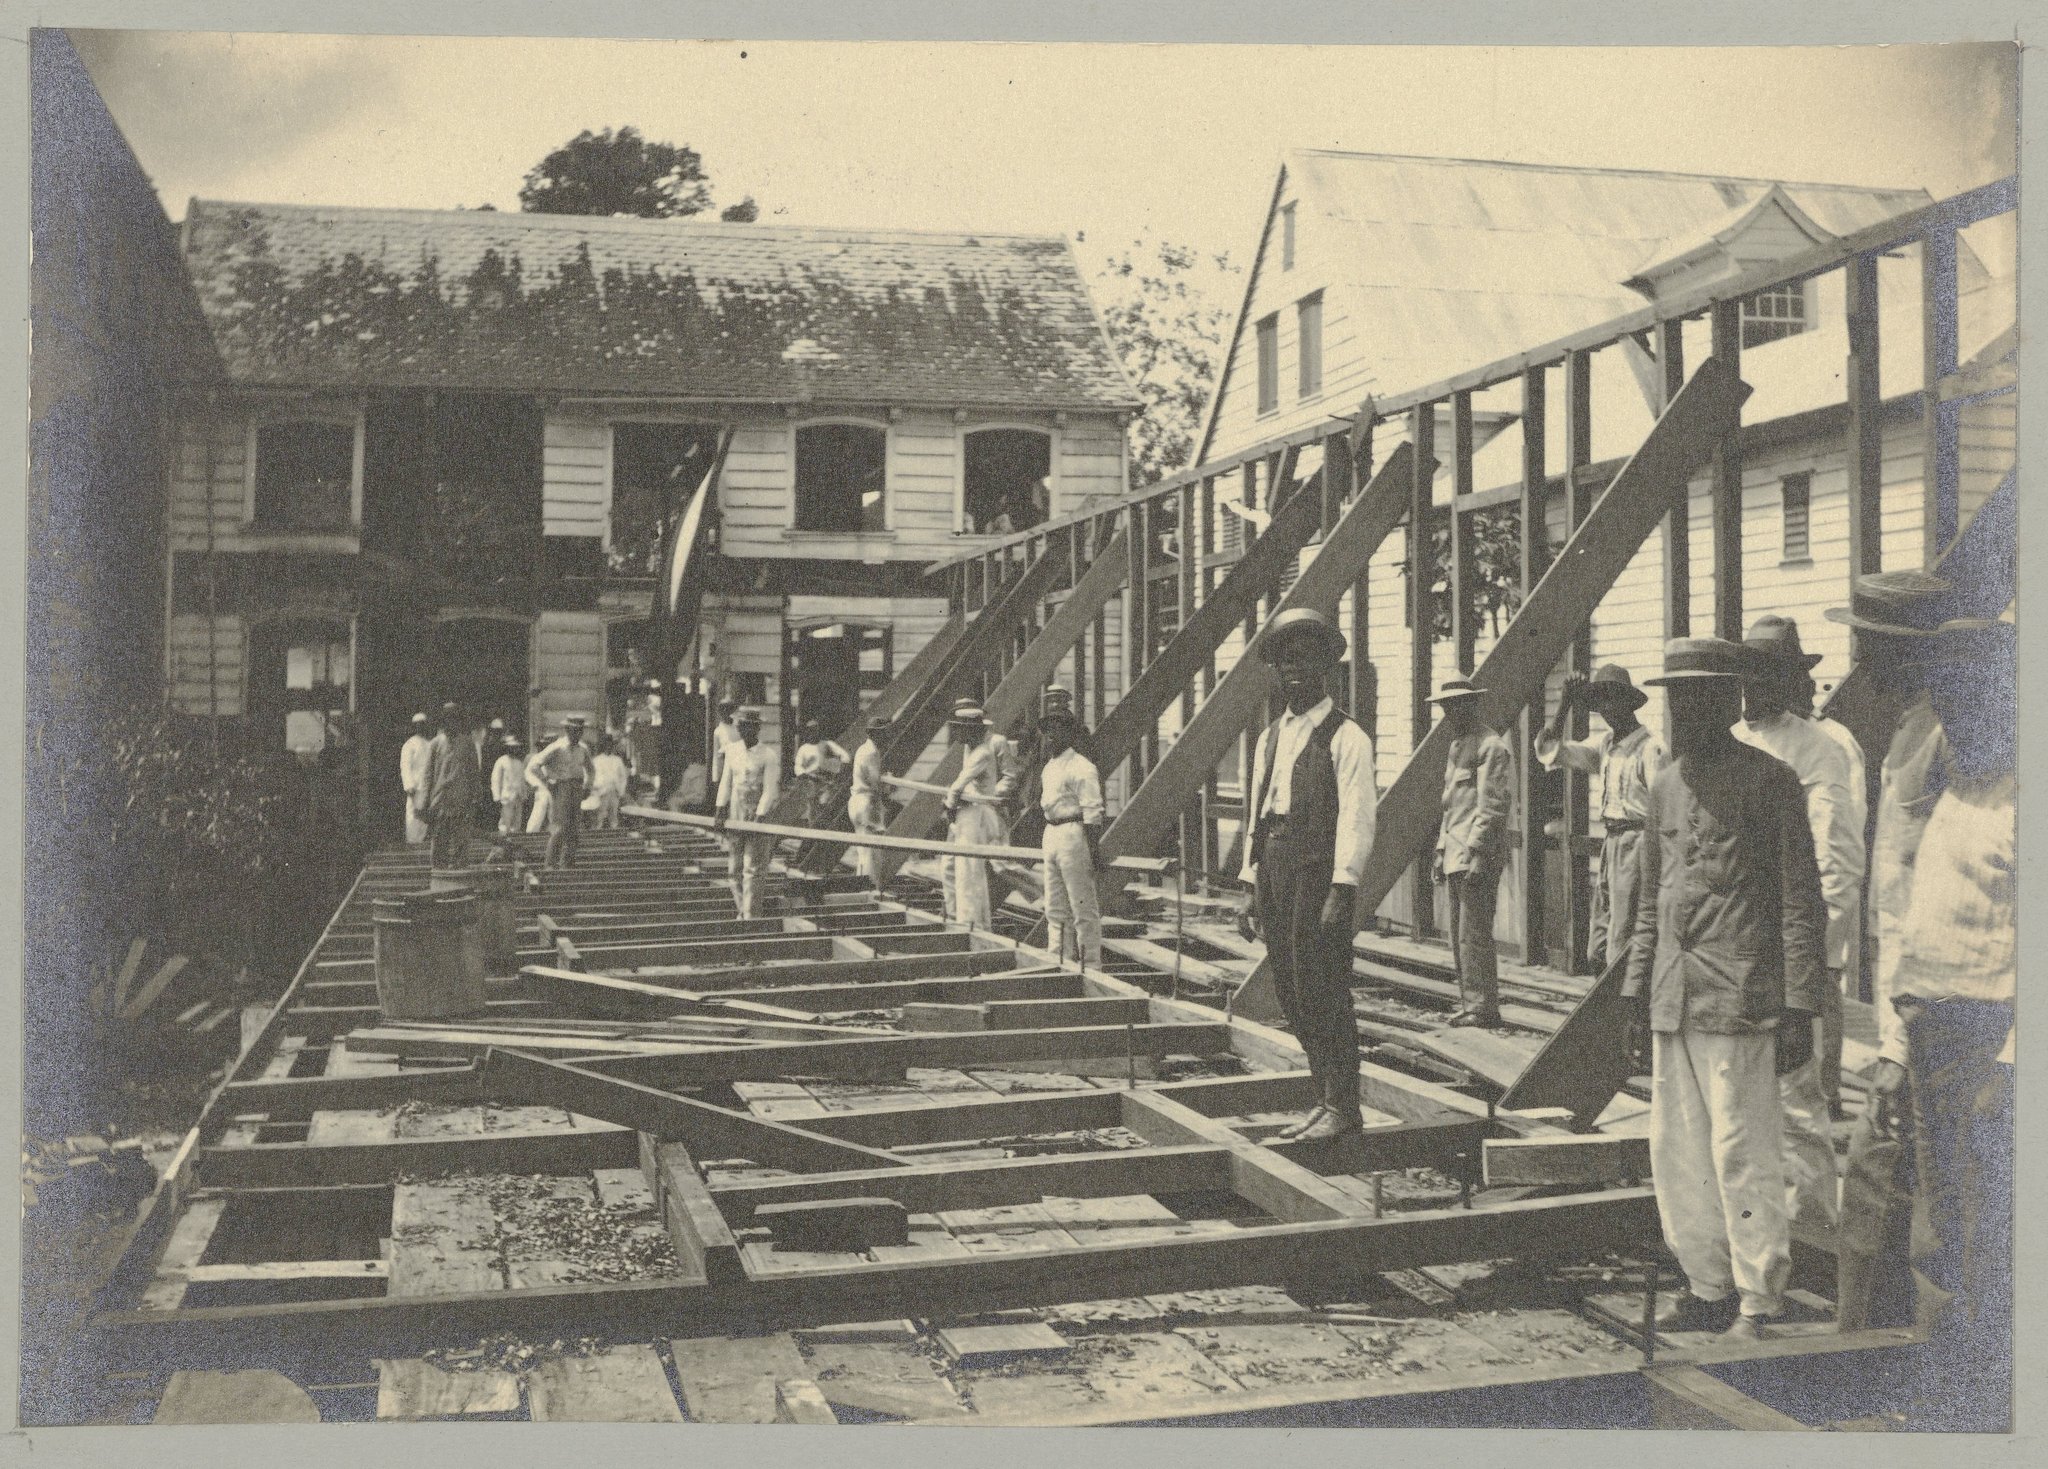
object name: photograph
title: Emmaschool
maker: hendrik doijer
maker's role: engineer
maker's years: 1863-1925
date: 1903-1910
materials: photographic support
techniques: gelatin silver print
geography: suriname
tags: suriname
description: De Emmaschool te Paramaribo in aanbouw, interieurgezicht met bouwvakkers die staan klaar om muurdelen op te rechten. Onderdeel van het fotoalbum Souvenir de Voyage (deel 4), over het leven van de familie Doijer in en rond de plantage Ma Retraite in Suriname in de jaren 1903-1910.